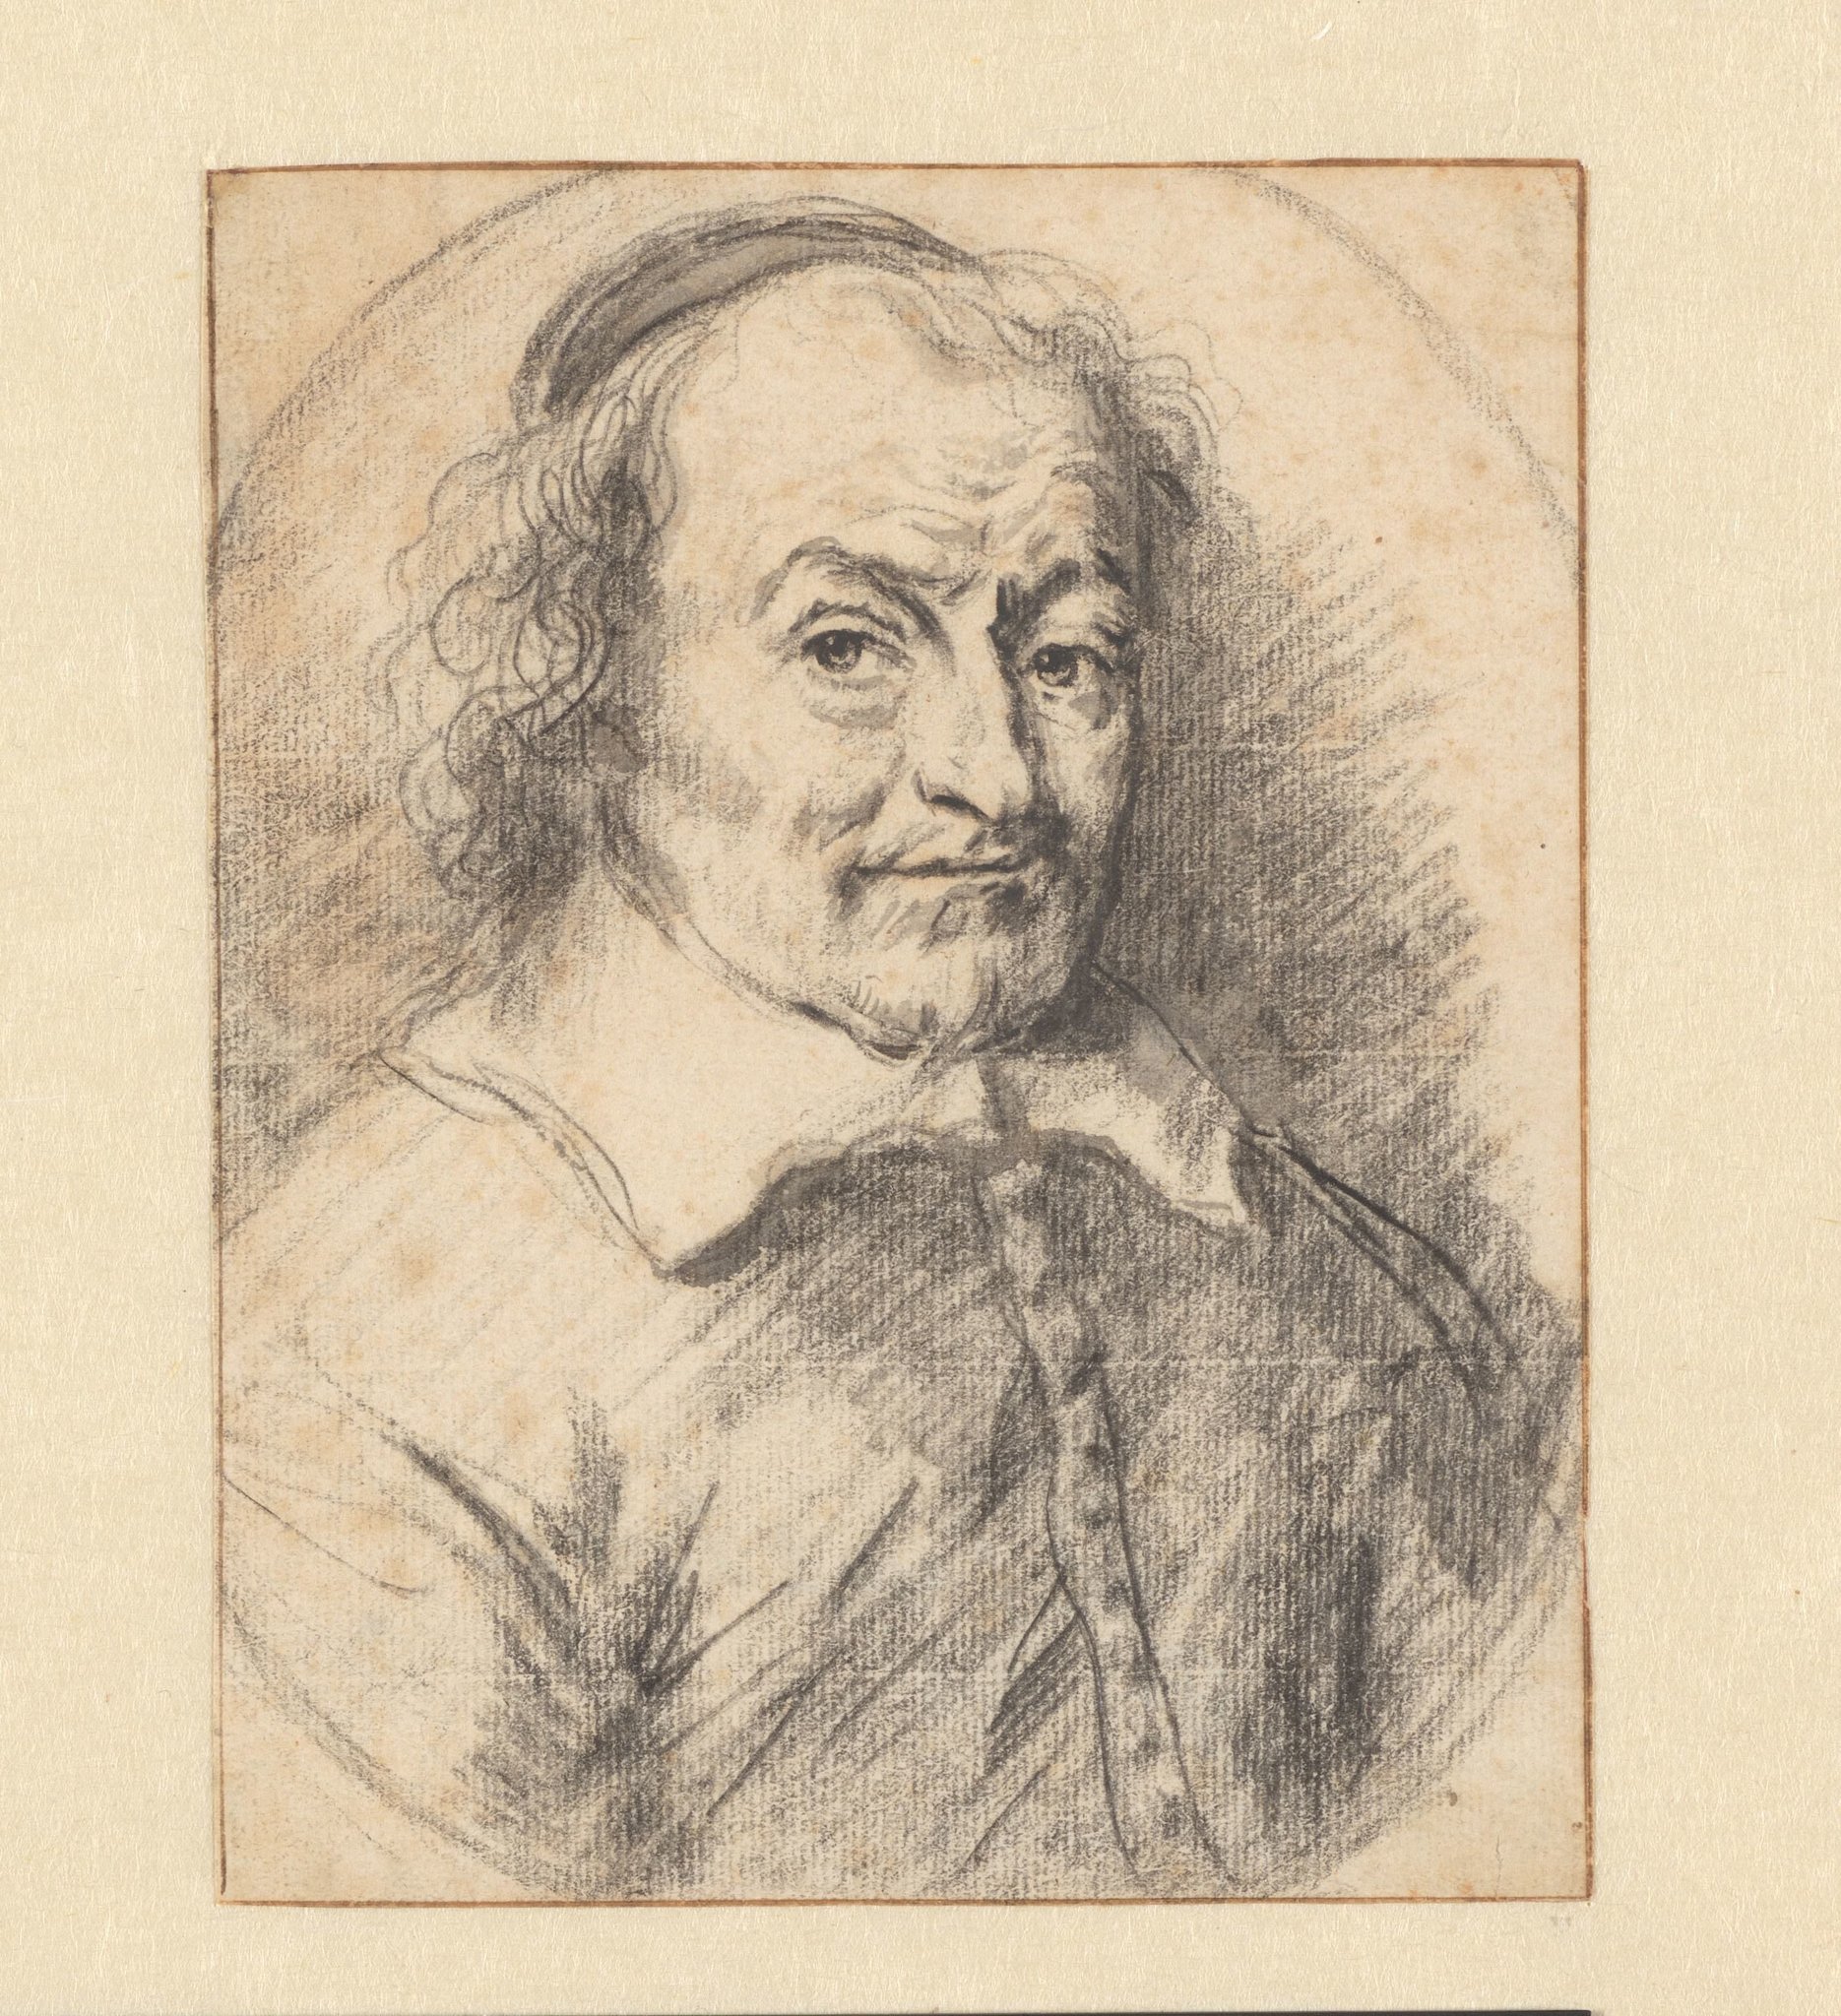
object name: drawing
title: Portret van Joost van den Vondel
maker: philips koninck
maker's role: draughtsman, painter, print maker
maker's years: 1619-1688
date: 1660-1665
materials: chalk, paper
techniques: brush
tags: amsterdam, joost van den vondel, historical persons, portrait of a writer